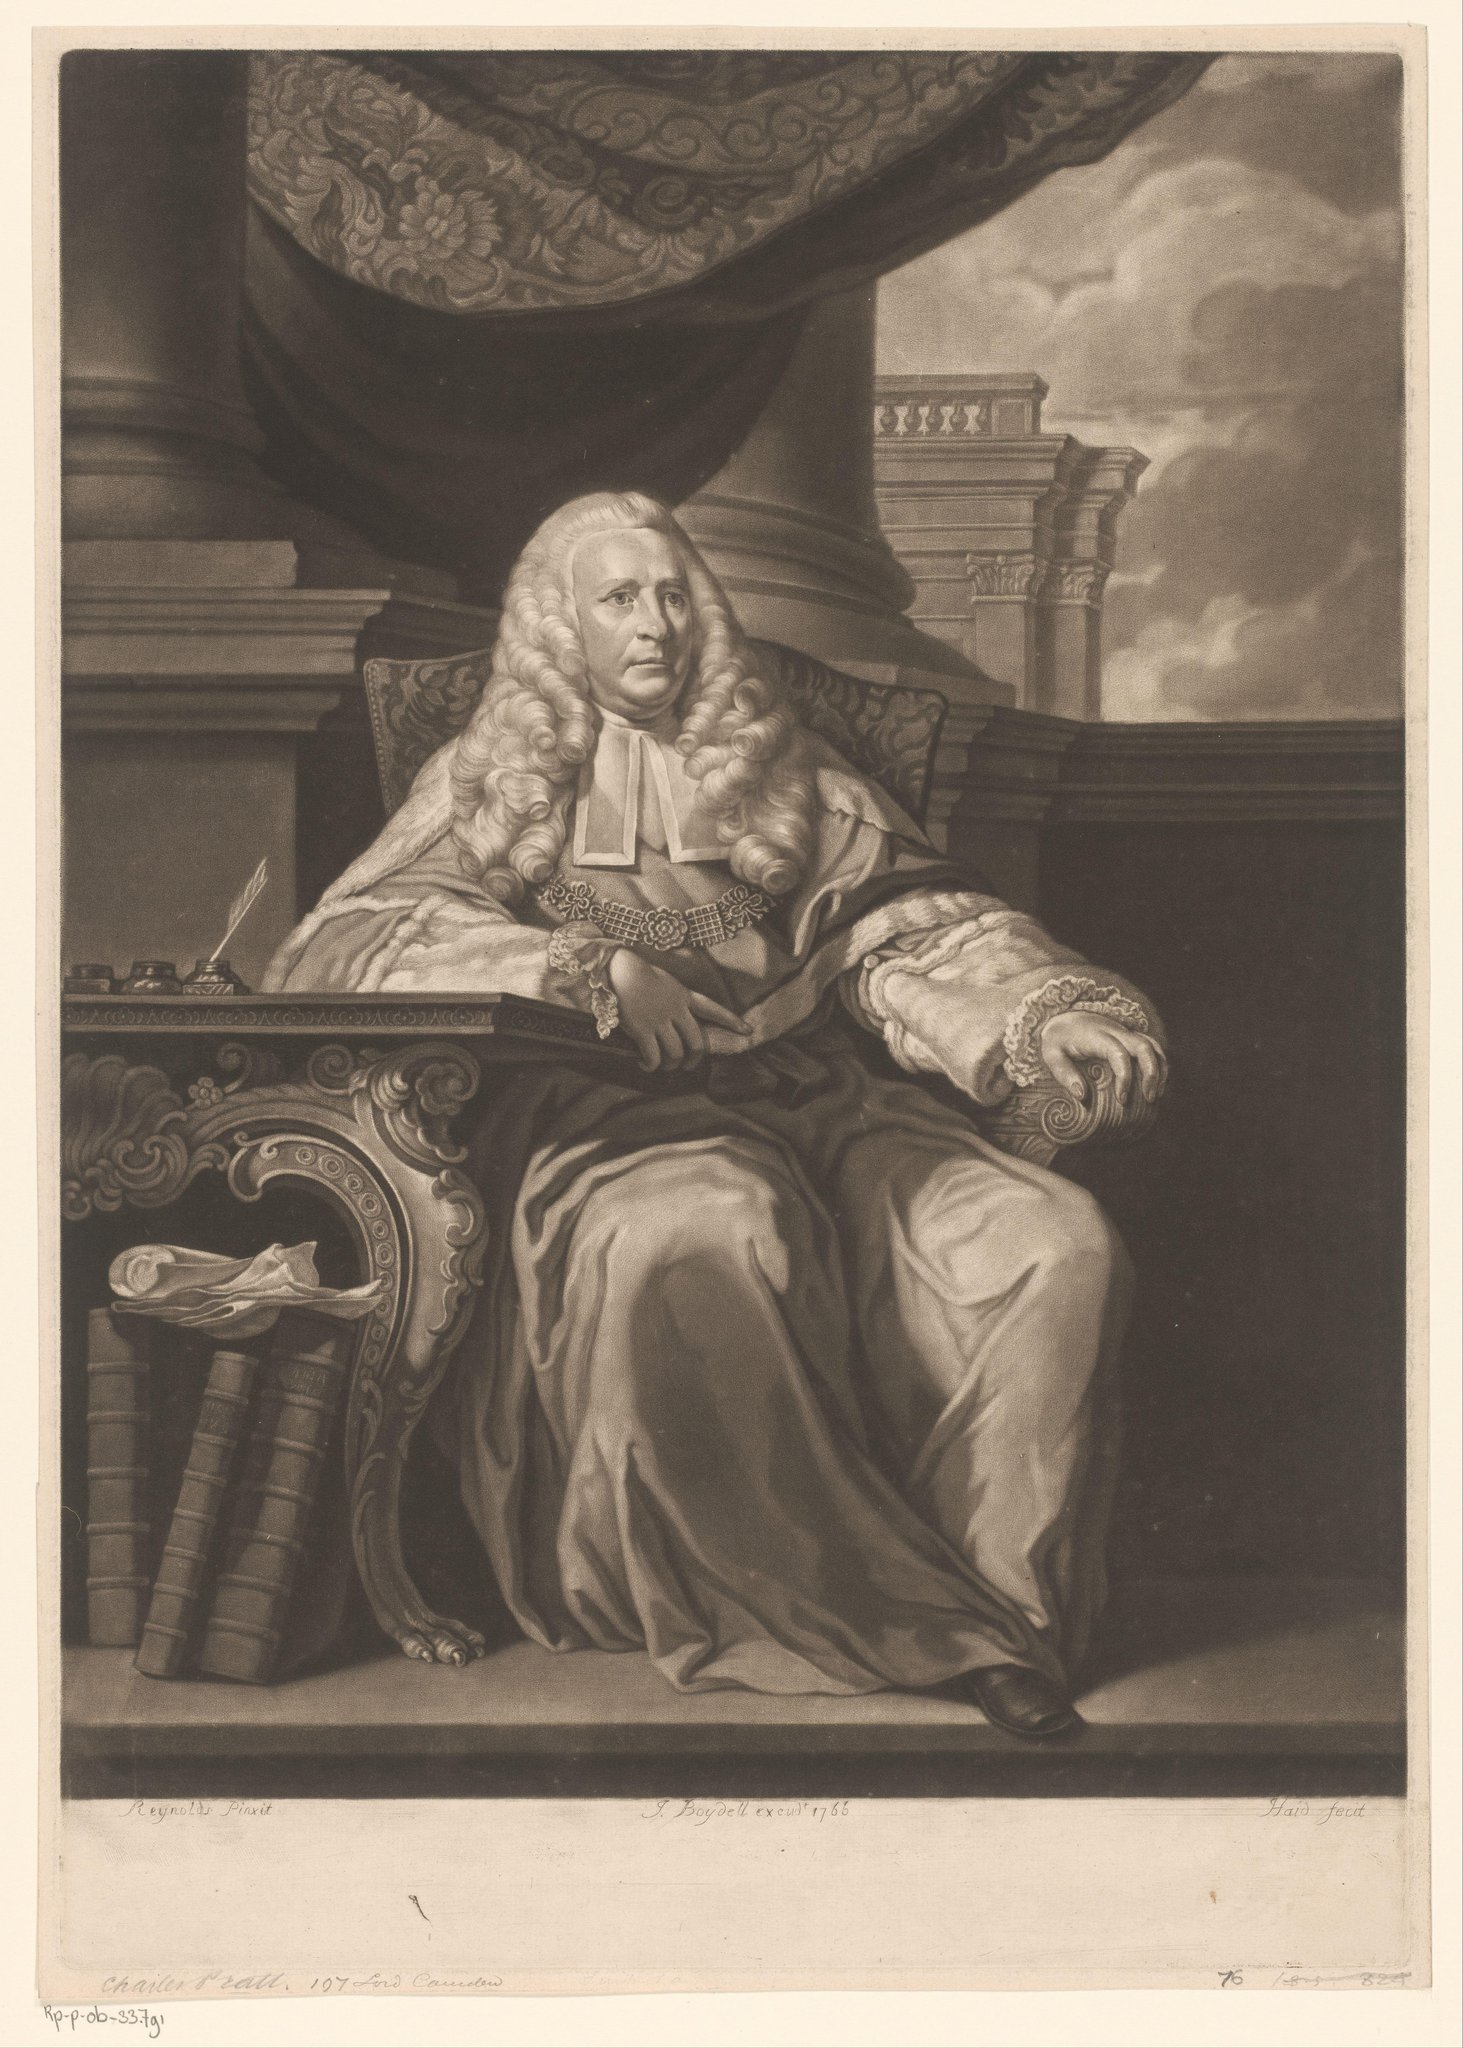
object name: print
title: Portret van Charles Pratt Camden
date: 1766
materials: paper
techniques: mezzotint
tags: politician, writing tools, historical persons, book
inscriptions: collector's mark: Lugt 240